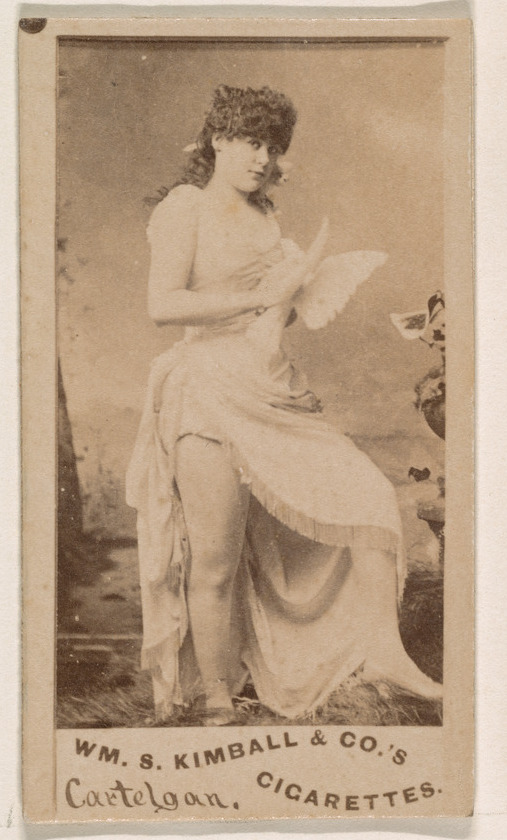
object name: photograph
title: Miss Cartelgan, from the Actresses series (N203) issued by Wm. S. Kimball & Co.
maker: william s. kimball & company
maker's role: publisher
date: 1889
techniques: color lithograph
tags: portraits,women,actresses